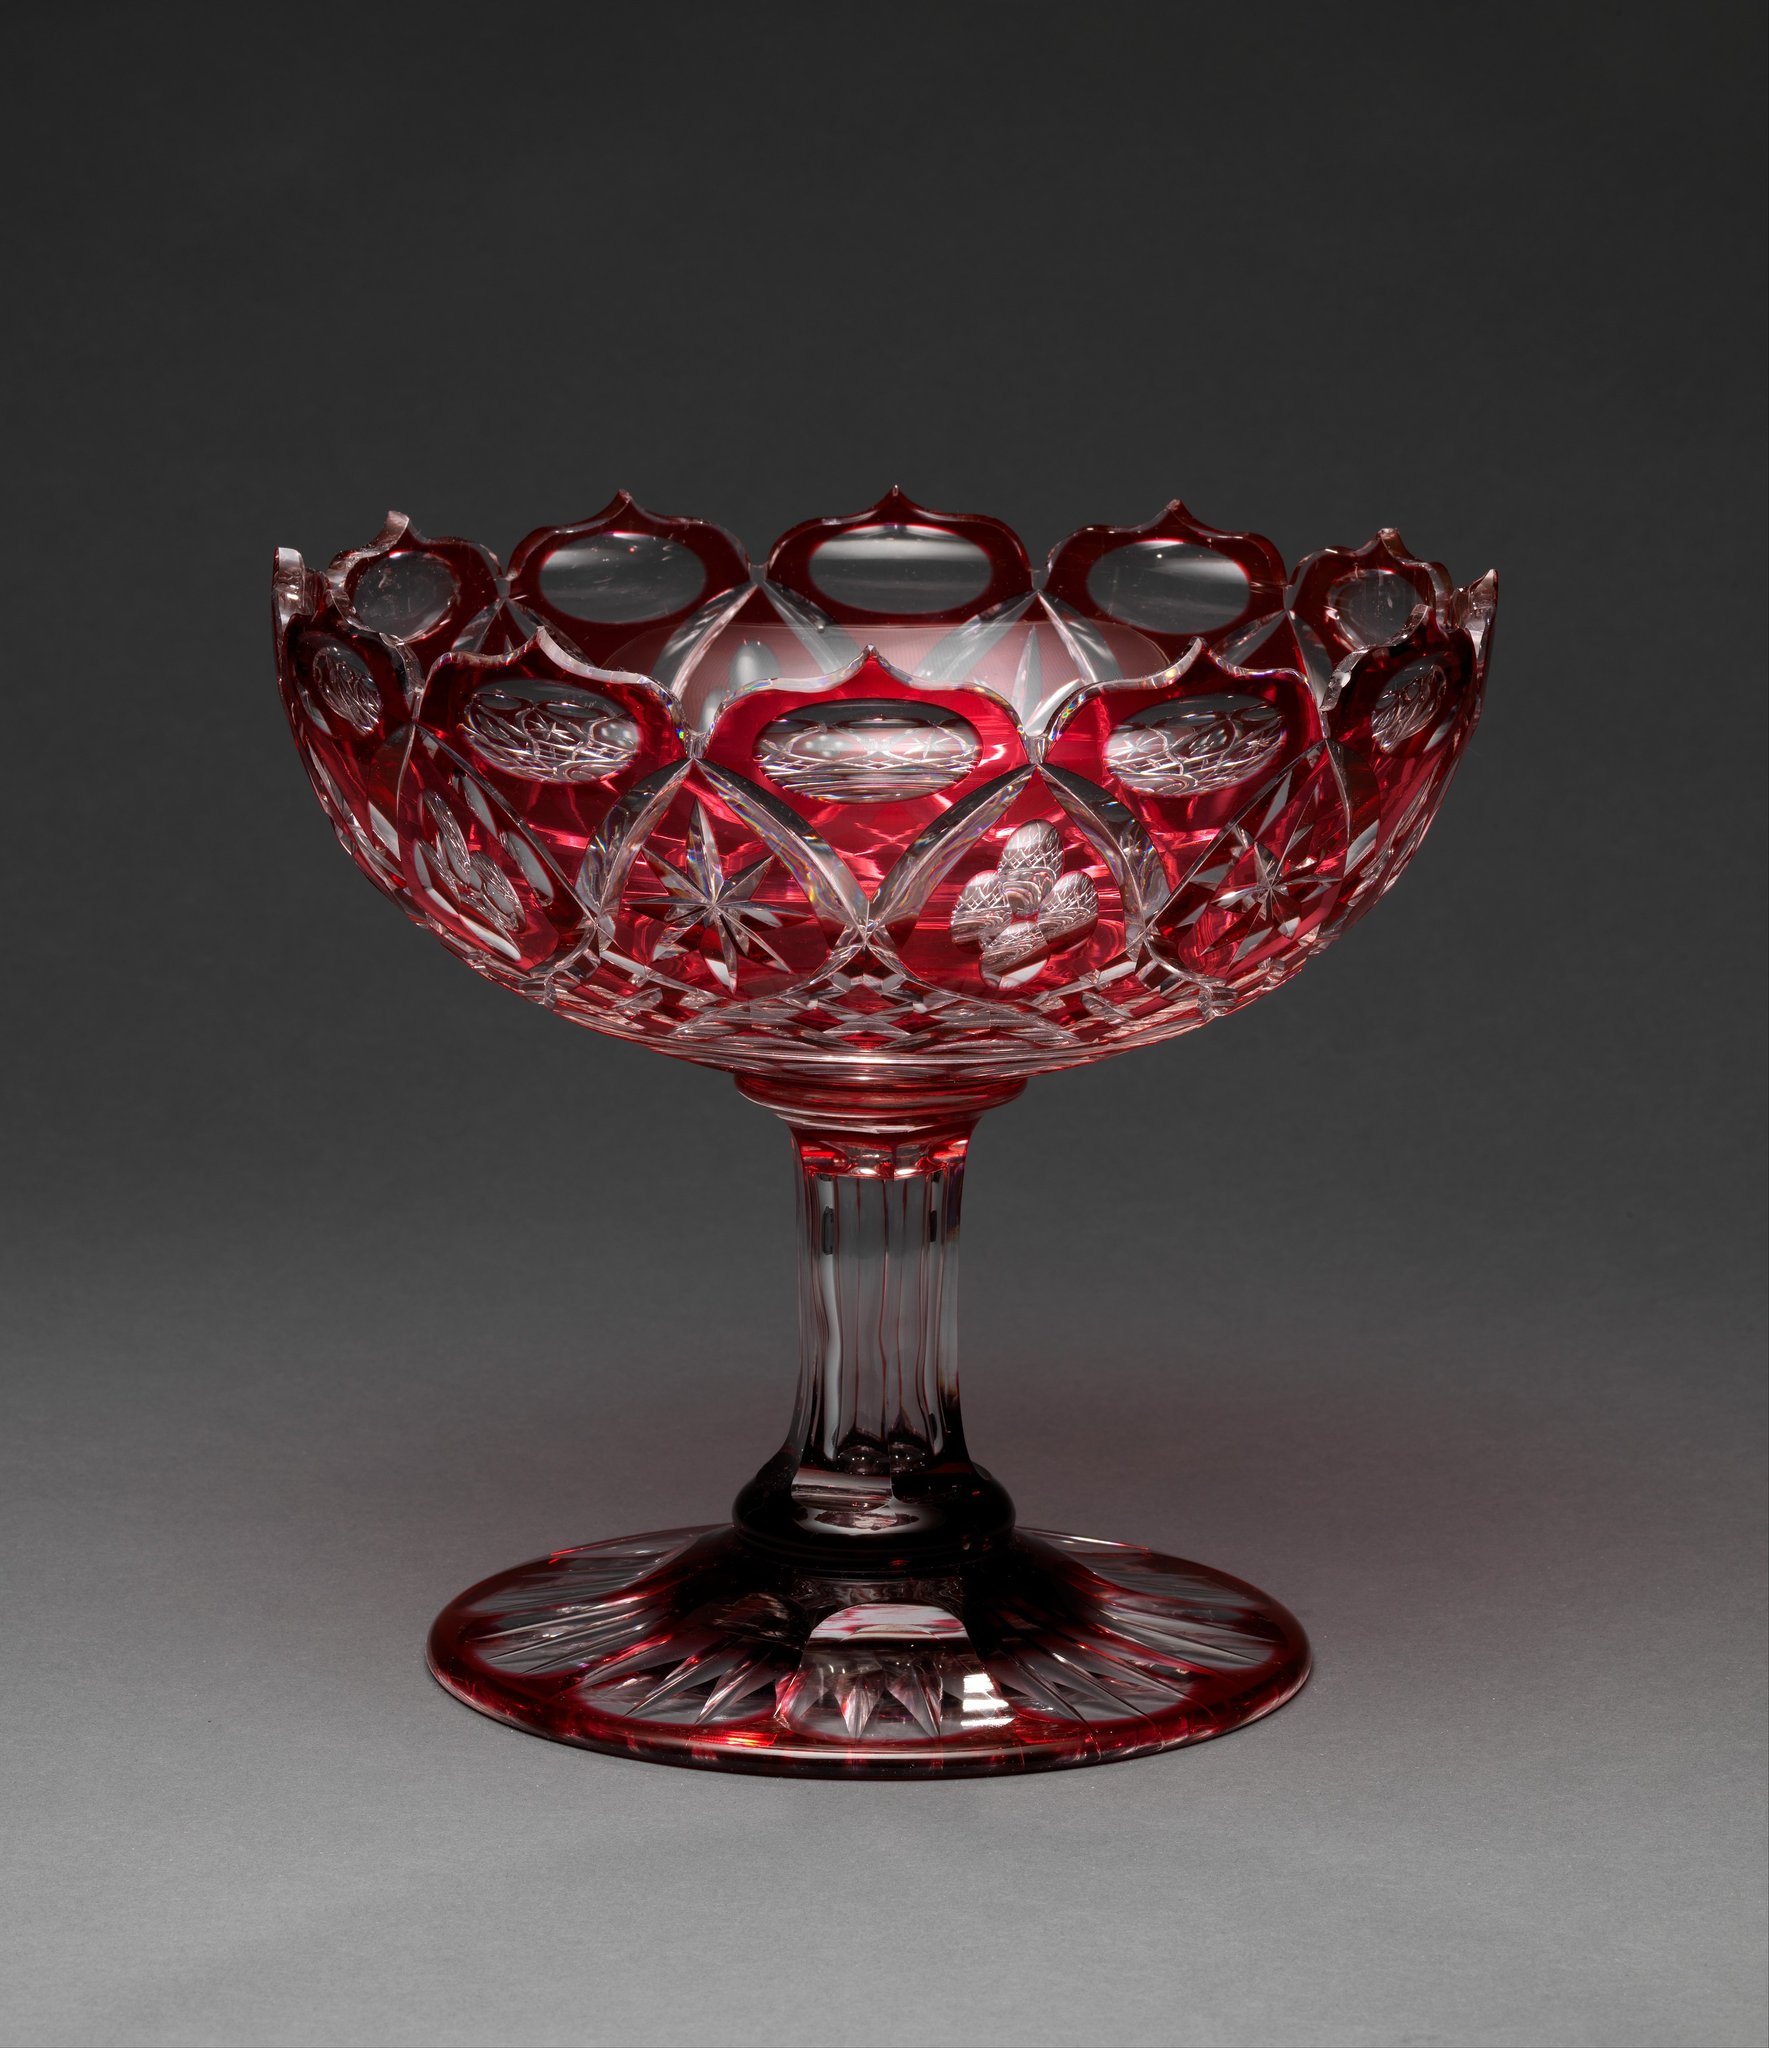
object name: compote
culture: american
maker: new england glass company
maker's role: manufacturer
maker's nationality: american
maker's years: 1818-1888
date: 1855-1870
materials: glass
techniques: cutting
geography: united states